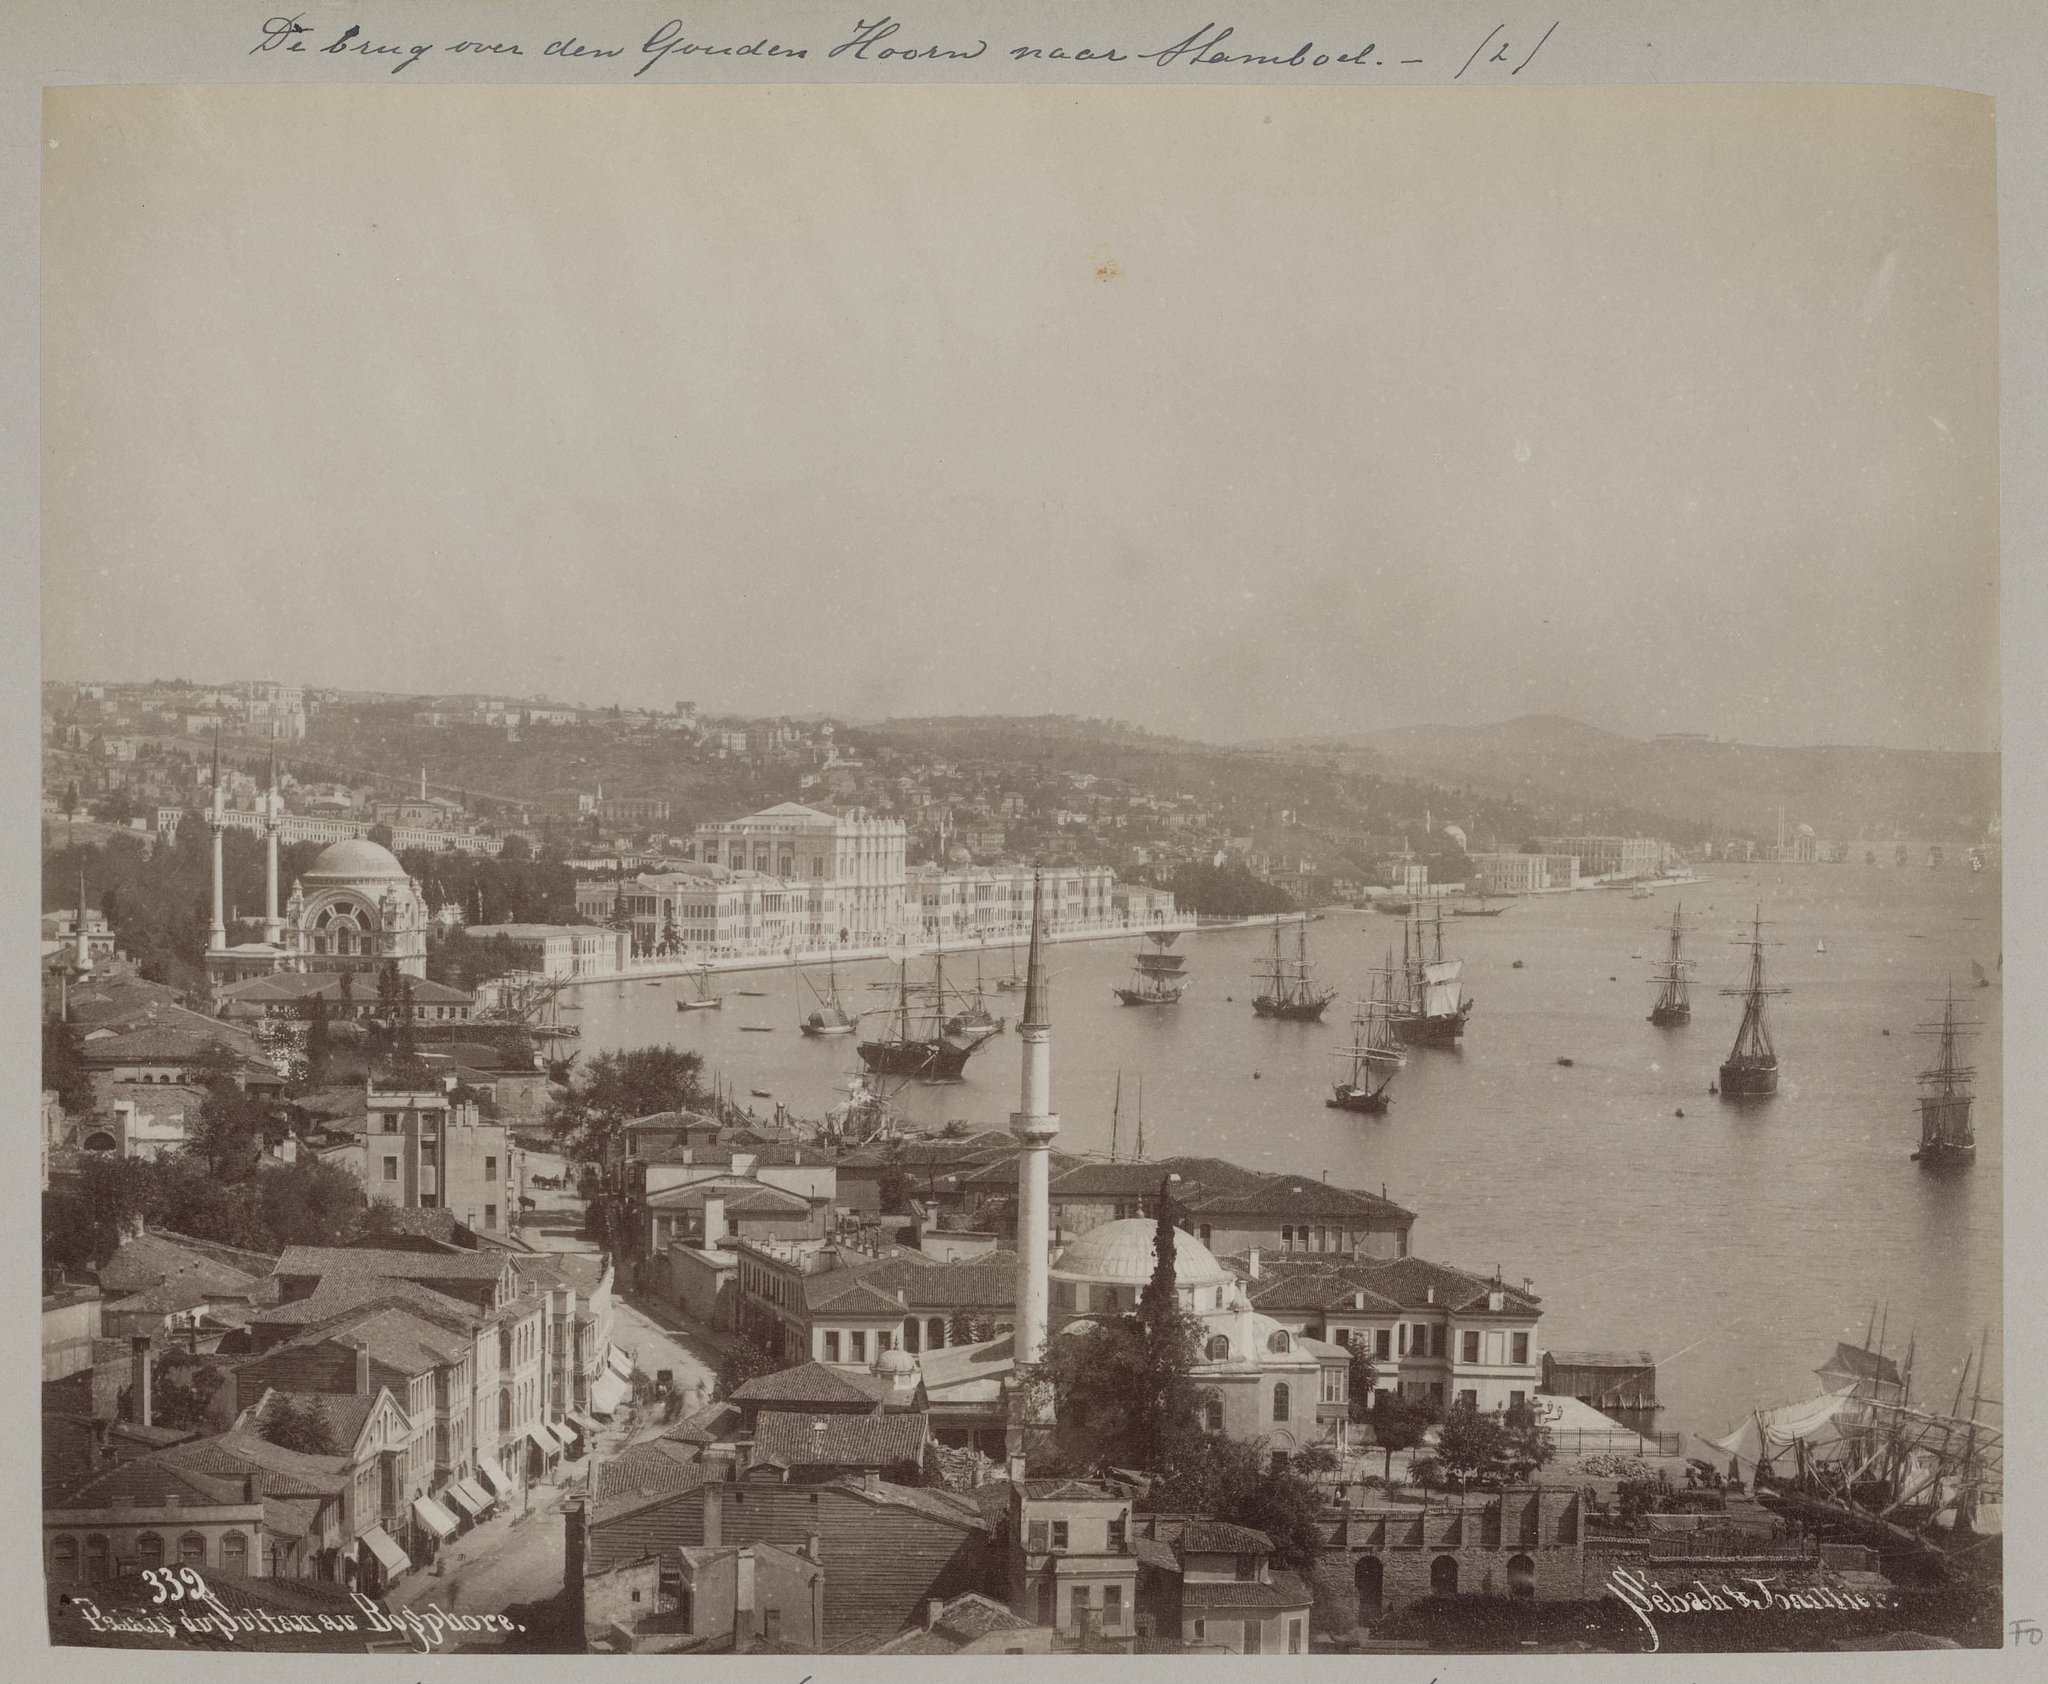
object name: photograph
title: Gezicht op Istanbul met centraal het Paleis van de Sultan aan de Bosporus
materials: photographic support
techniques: albumen print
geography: istanbul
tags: palace, prospect of city, town panorama, silhouette of city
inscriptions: number: ‘339’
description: Het bijschrift boven deze foto behoort bij foto RP-F-F01141-CD. Dat boven foto RP-F-F01141-CD bij deze foto.